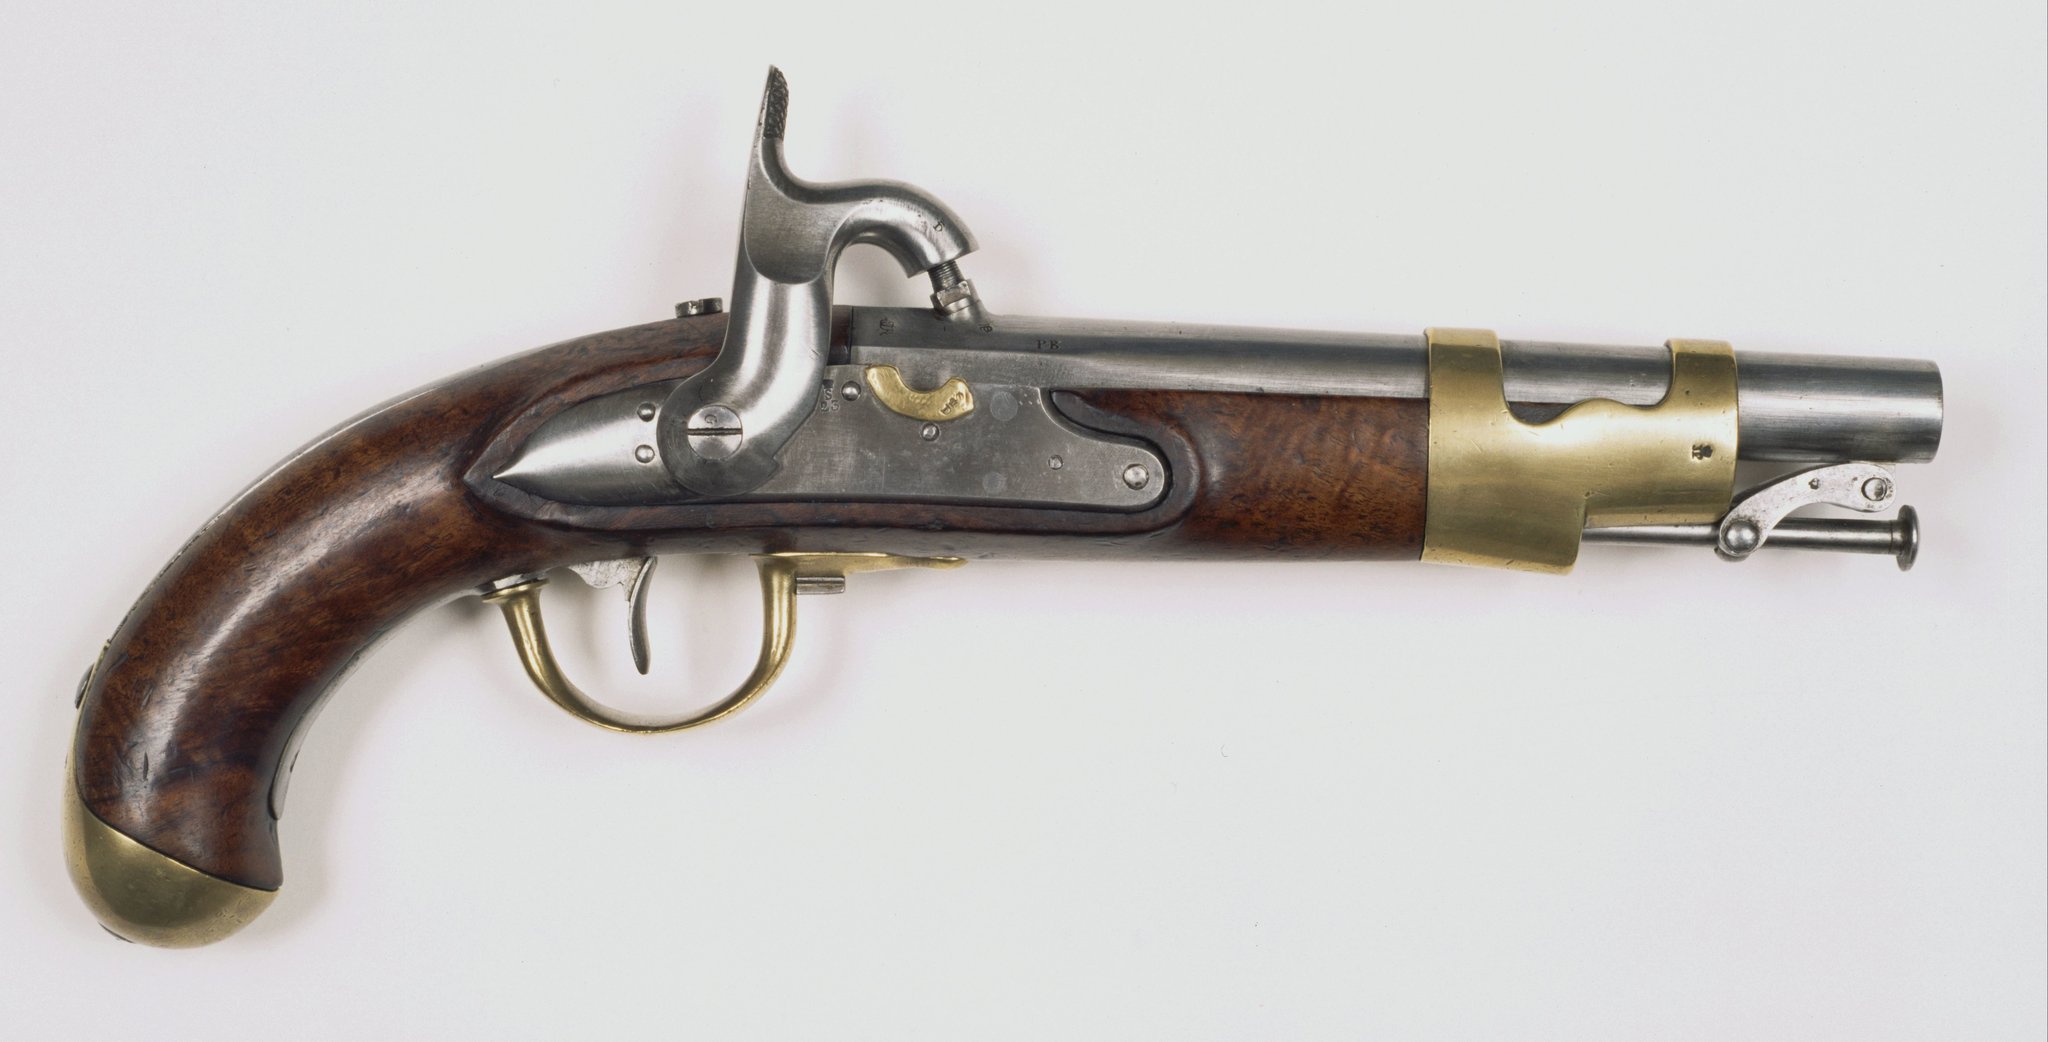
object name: pistol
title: Percussie Legerpistool Model M 1820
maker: Anonymous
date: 1820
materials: brass, iron, wood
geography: netherlands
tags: netherlands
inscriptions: signature: ‘JP met kroon’, signature: ‘D met kroon’, : ‘23’, signature: ‘PB // JR’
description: Percussie legerpistool model M 1820. met gladde, ronde loop, die bij de kamer in een vijfkantig gedeelte overgaat. De bovenzijde van de kamer een ingetapte percussieschouw. IJzeren slotplaat met een ingkerfde 'S' met een kroon erboven en het ingekerfde cijfer '23'. Aan de bovenzijde van de haan een grote ring. De kolf is van notenhout en heeft aan het uiteinde een messing kolfkap met een ijzeren schroef. De lade is van notenhout en heeft aan de voorkant een opengewerkte huls. Trekkerbeugel van messing met een ijzeren trekker.